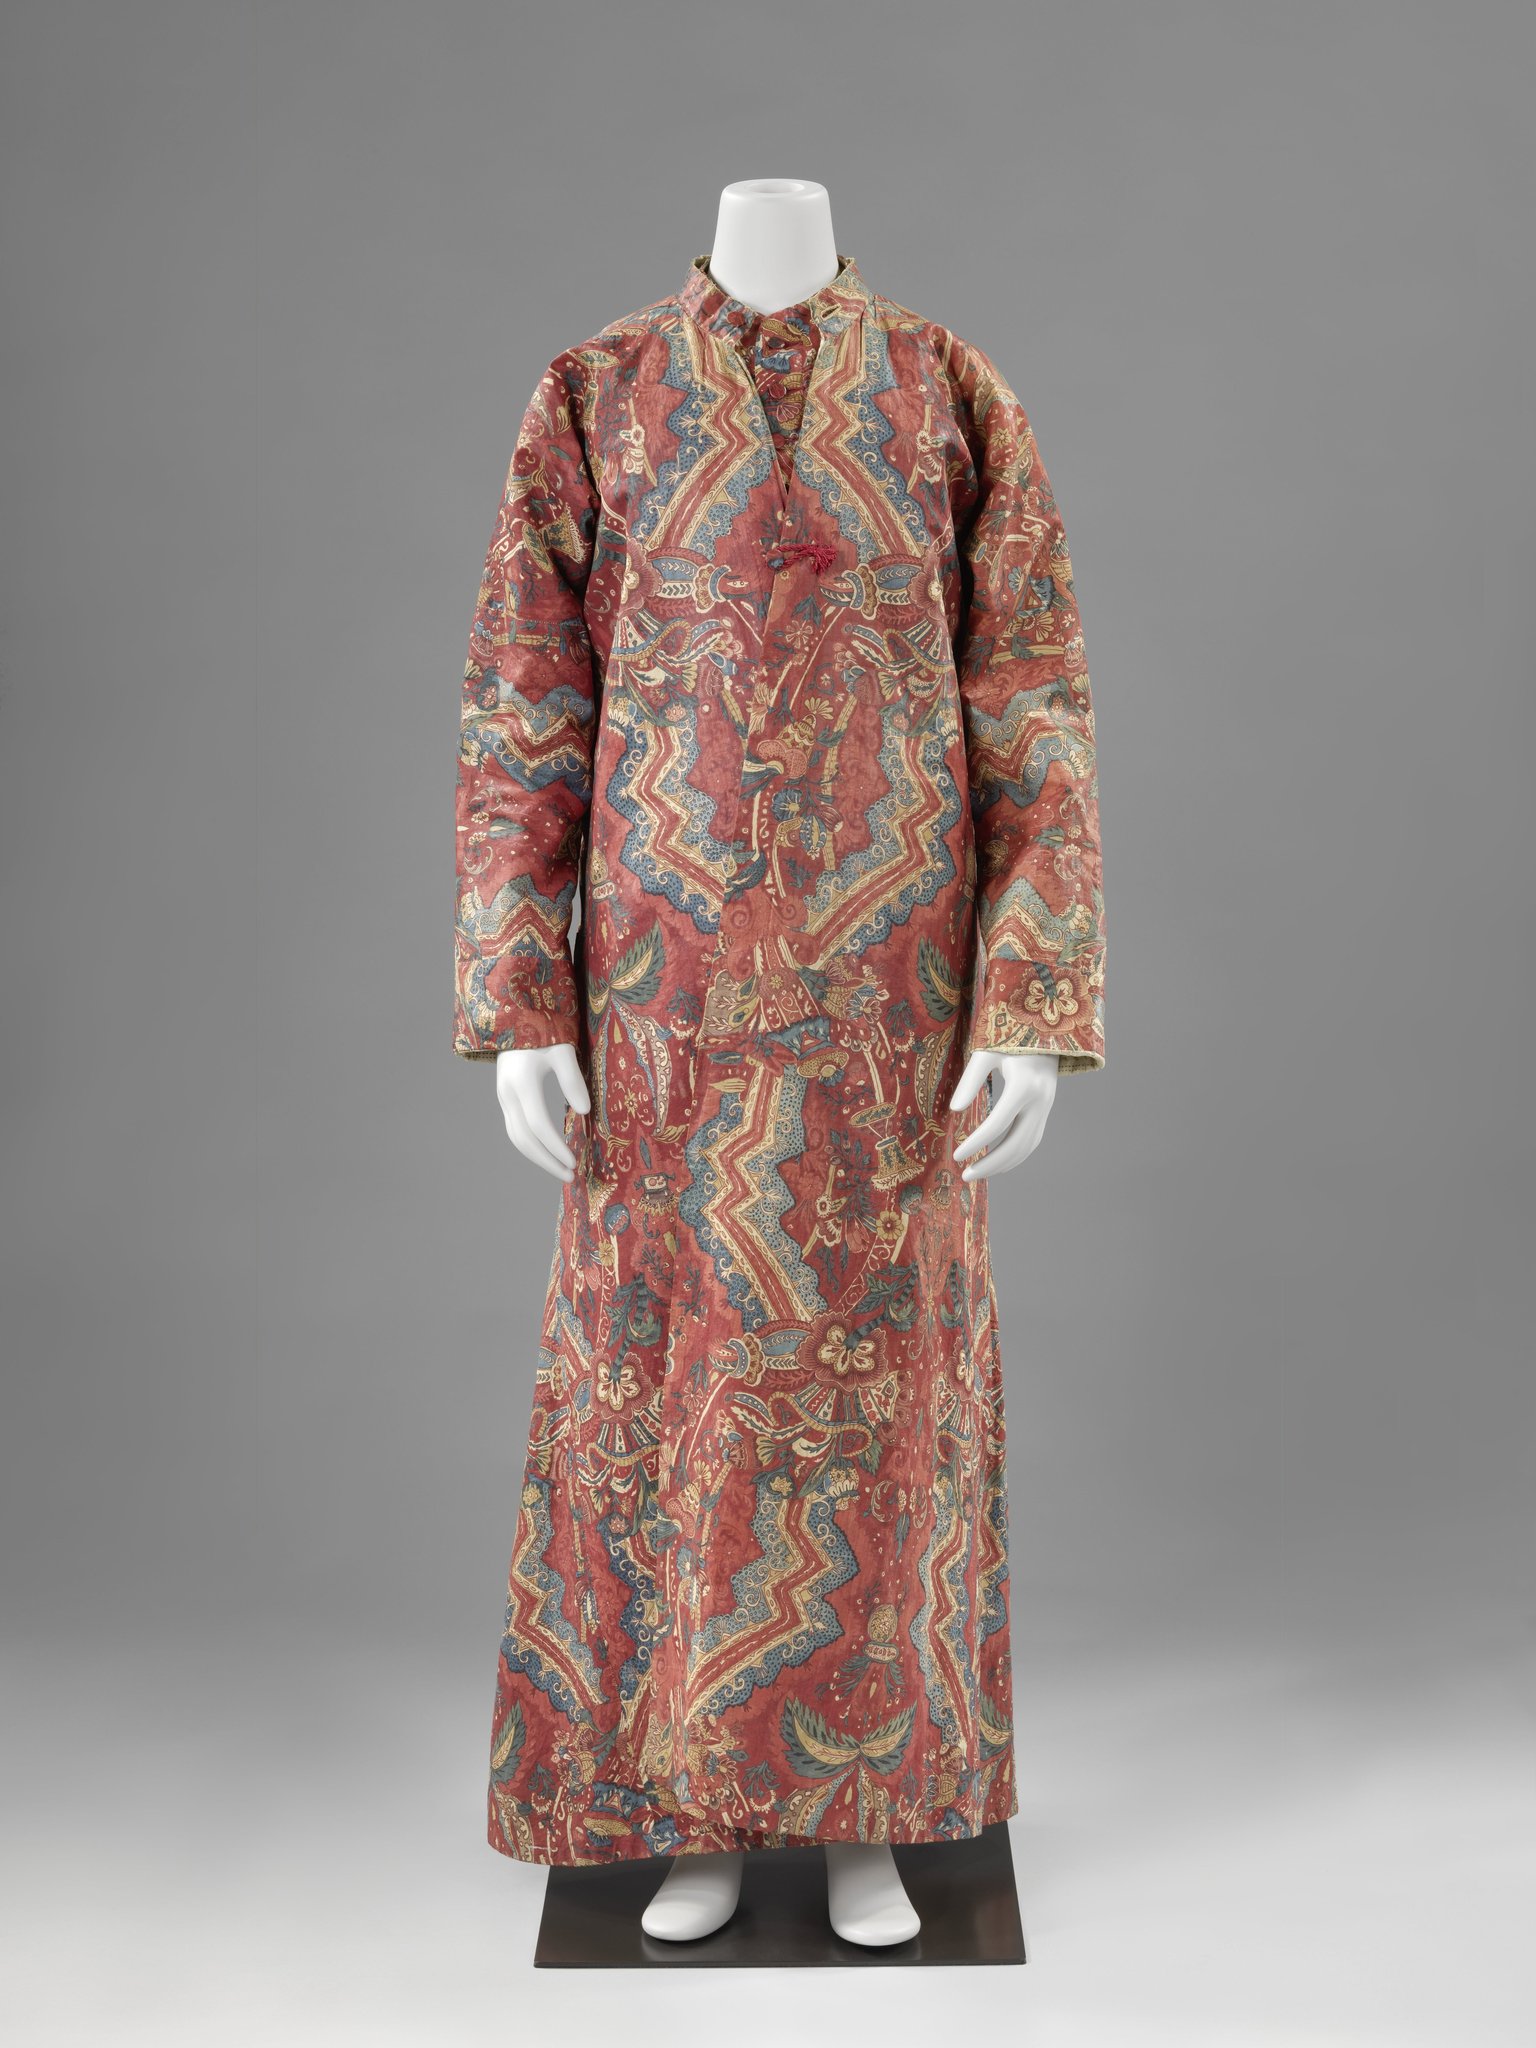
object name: huisjas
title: Housecoat with Waistcoat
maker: Anonymous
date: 1740-1770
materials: textile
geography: haarlem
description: The pattern of this chintz is a mix of European stylistic elements from different periods in the 18th century, based on so-called lace-patterned silks. This robe and matching waistcoat were probably made in the Netherlands. The material used to line the robe of sewn, striped silk may have been woven in Haarlem.